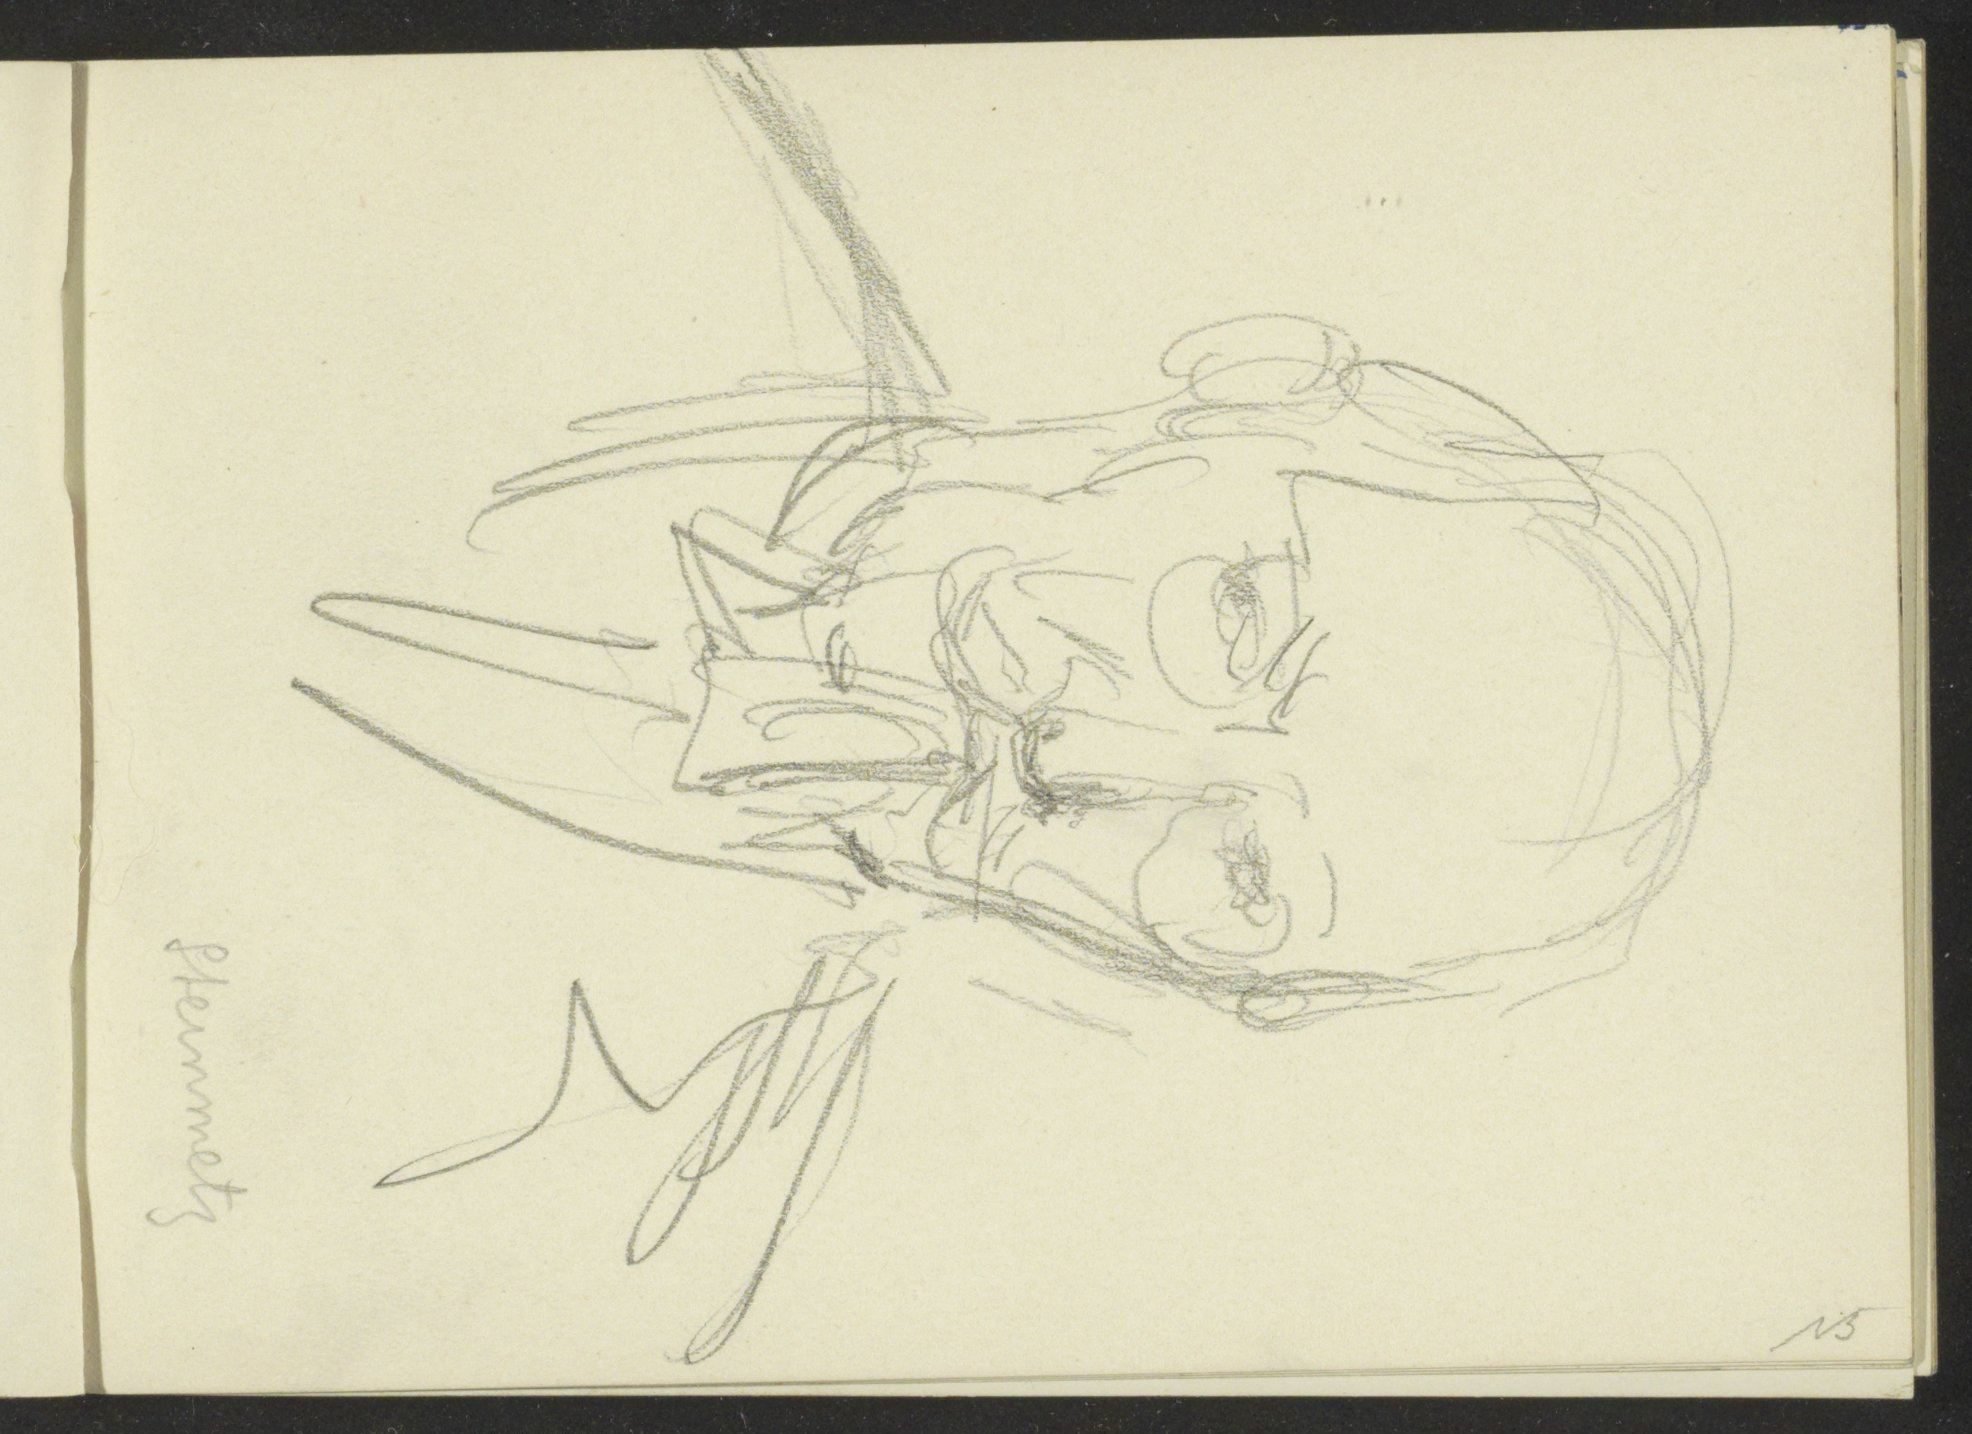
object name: sketchbook leaf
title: Portret van Sebald Rudolf Steinmetz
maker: isaac israels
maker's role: draughtsman, painter, print maker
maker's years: 1865-1934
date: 1875-1934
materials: paper, pencil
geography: the hague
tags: historical persons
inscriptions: annotation: ‘Steinmetz’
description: Blad 15 recto uit schetsboek LVII met 29 bladen.